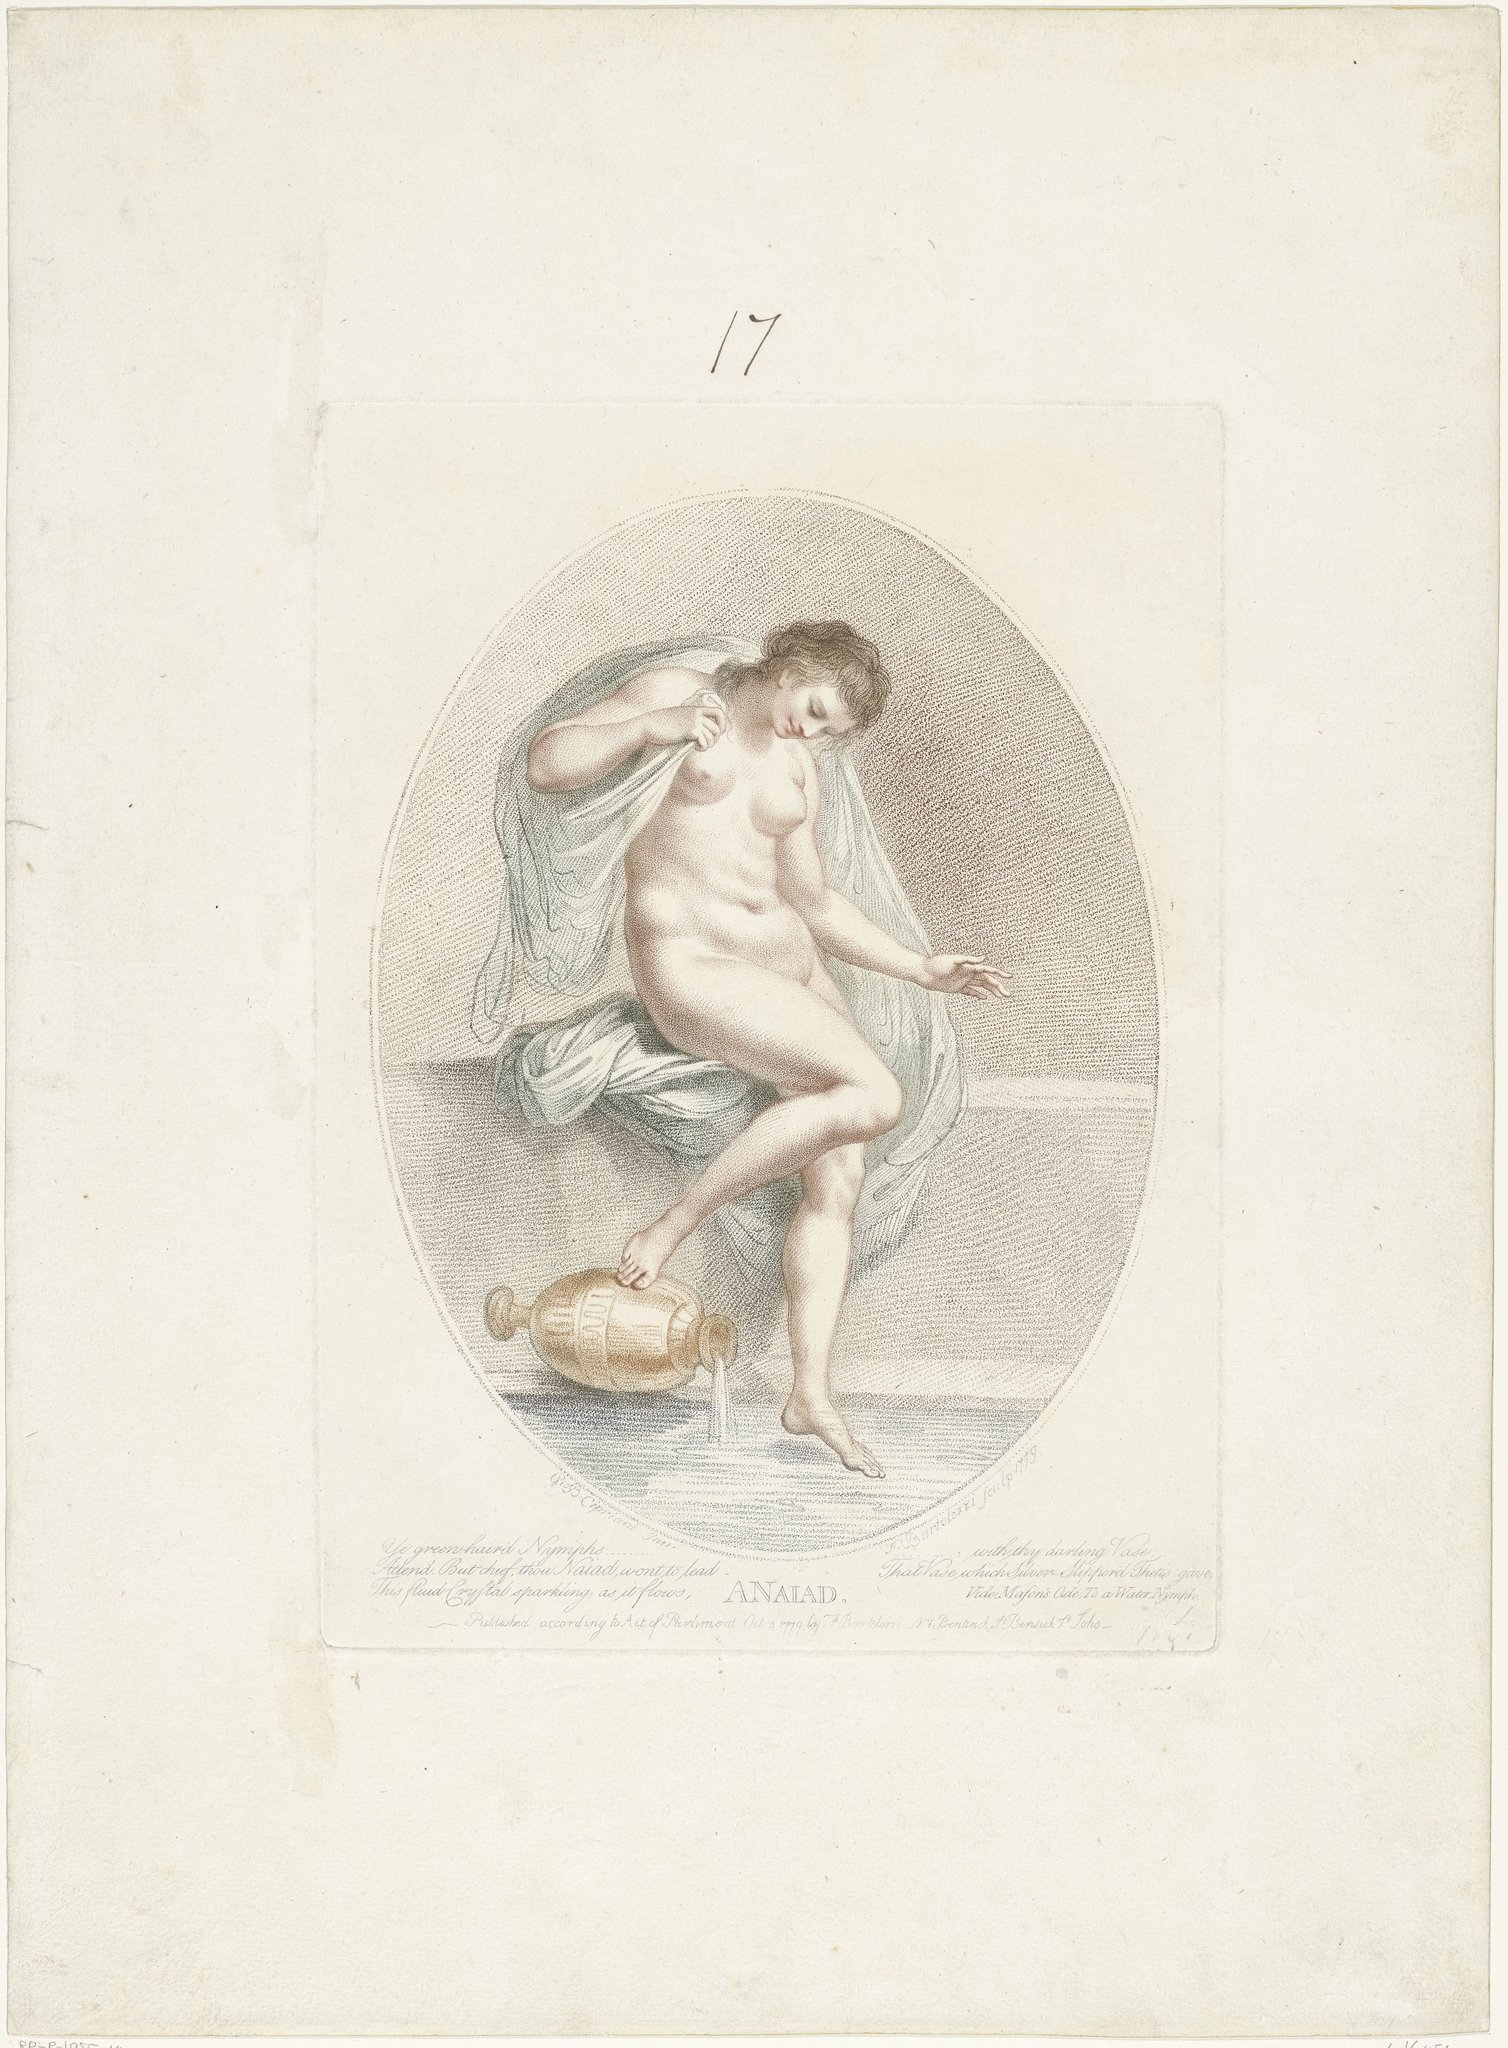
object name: print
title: A Naiad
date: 1779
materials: paper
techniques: printmaking, etching, lithography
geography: london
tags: naiads, river- and spring-nymphs; usually carrying an urn; 'naiadi, ninfe de' fiumi' (ripa)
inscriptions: collector's mark: Lugt 2228, number: ‘17’, collector's mark: Lugt 2760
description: Een waternimf zittend op een muurtje. Met haar ene voet zit zij in het water en met de andere steunt zij op een kruik.